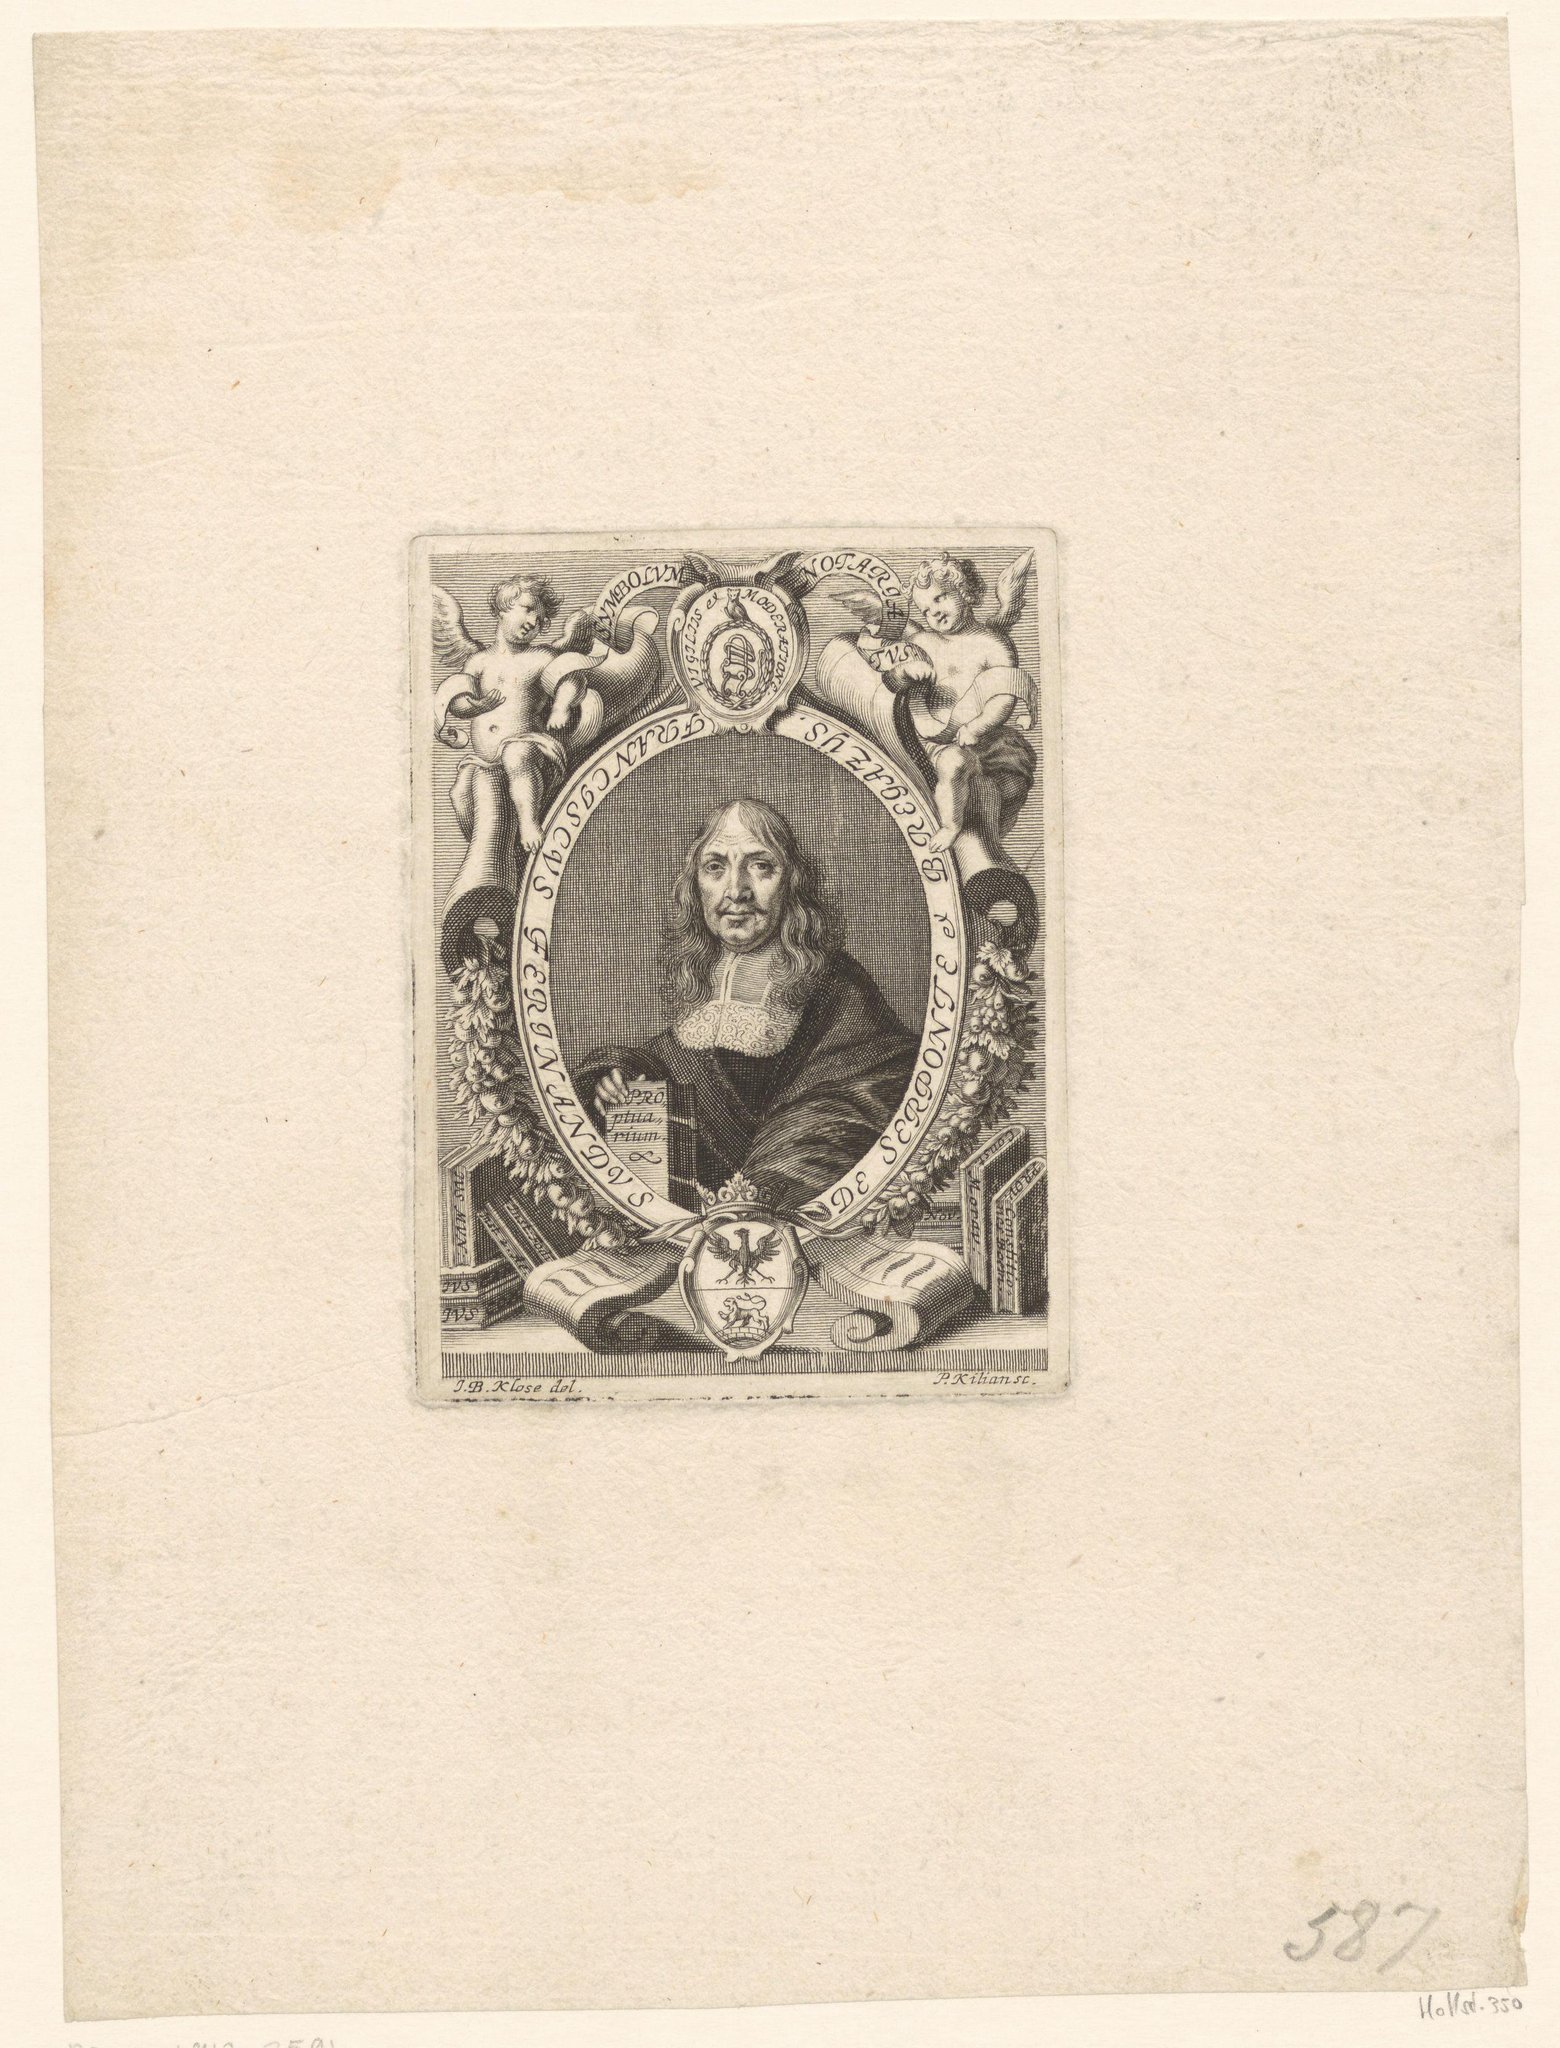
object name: print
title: Portret van Franciscus Ferdinandus de Serponte et Bregaziis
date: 1638-1693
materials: paper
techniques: engraving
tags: historical persons, lawyer, attorney at law, portrait of a writer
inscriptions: collector's mark: Lugt 2228